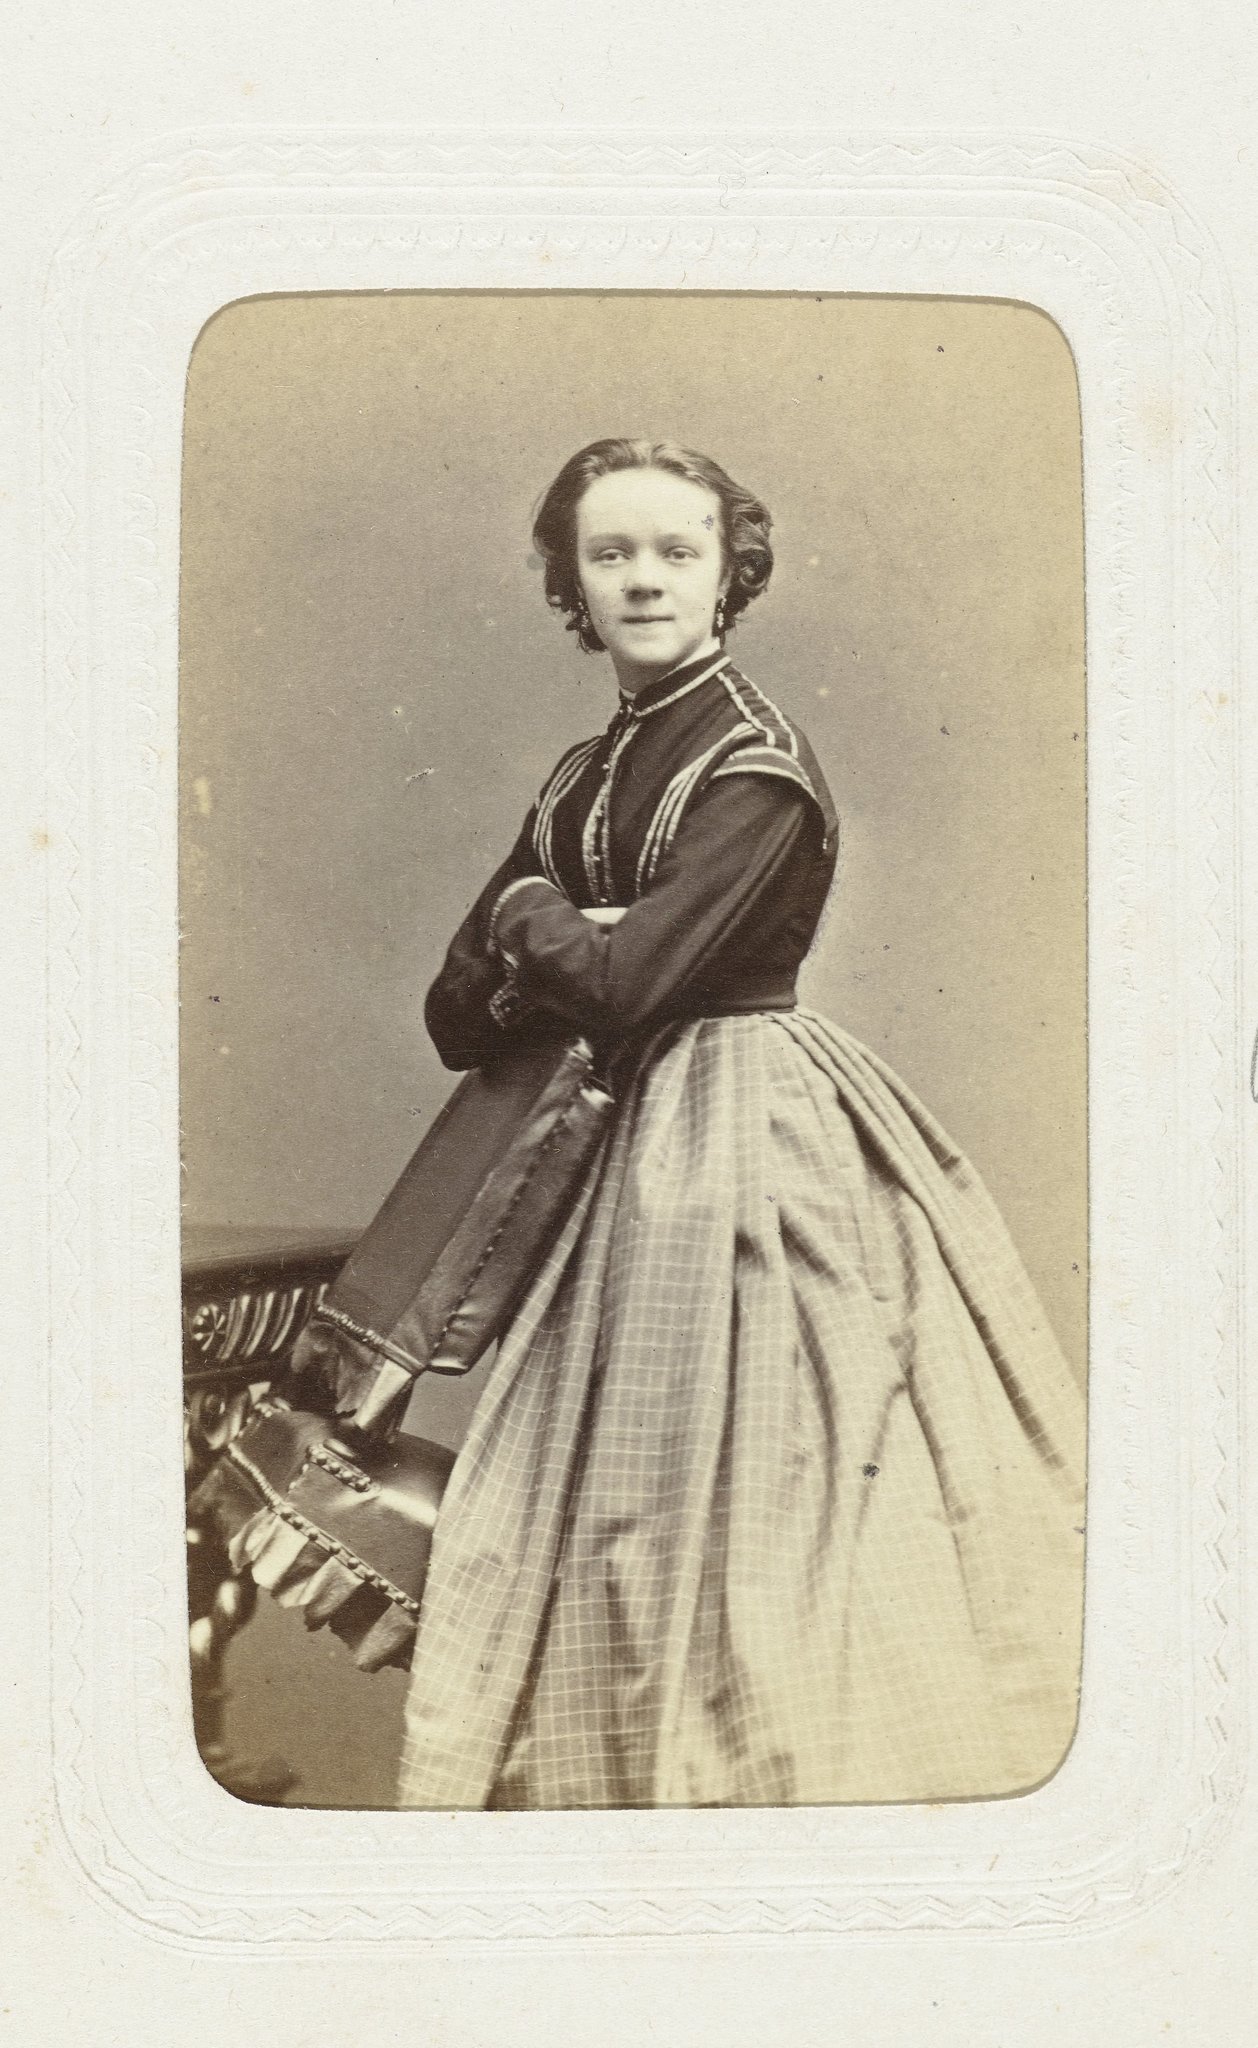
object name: carte de visite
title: Studioportret van een jonge vrouw in een lange bolle rok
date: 1863-1866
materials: cardboard, paper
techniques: albumen print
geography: amsterdam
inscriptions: name: ‘Wegner & Mottu, Amsterdam’